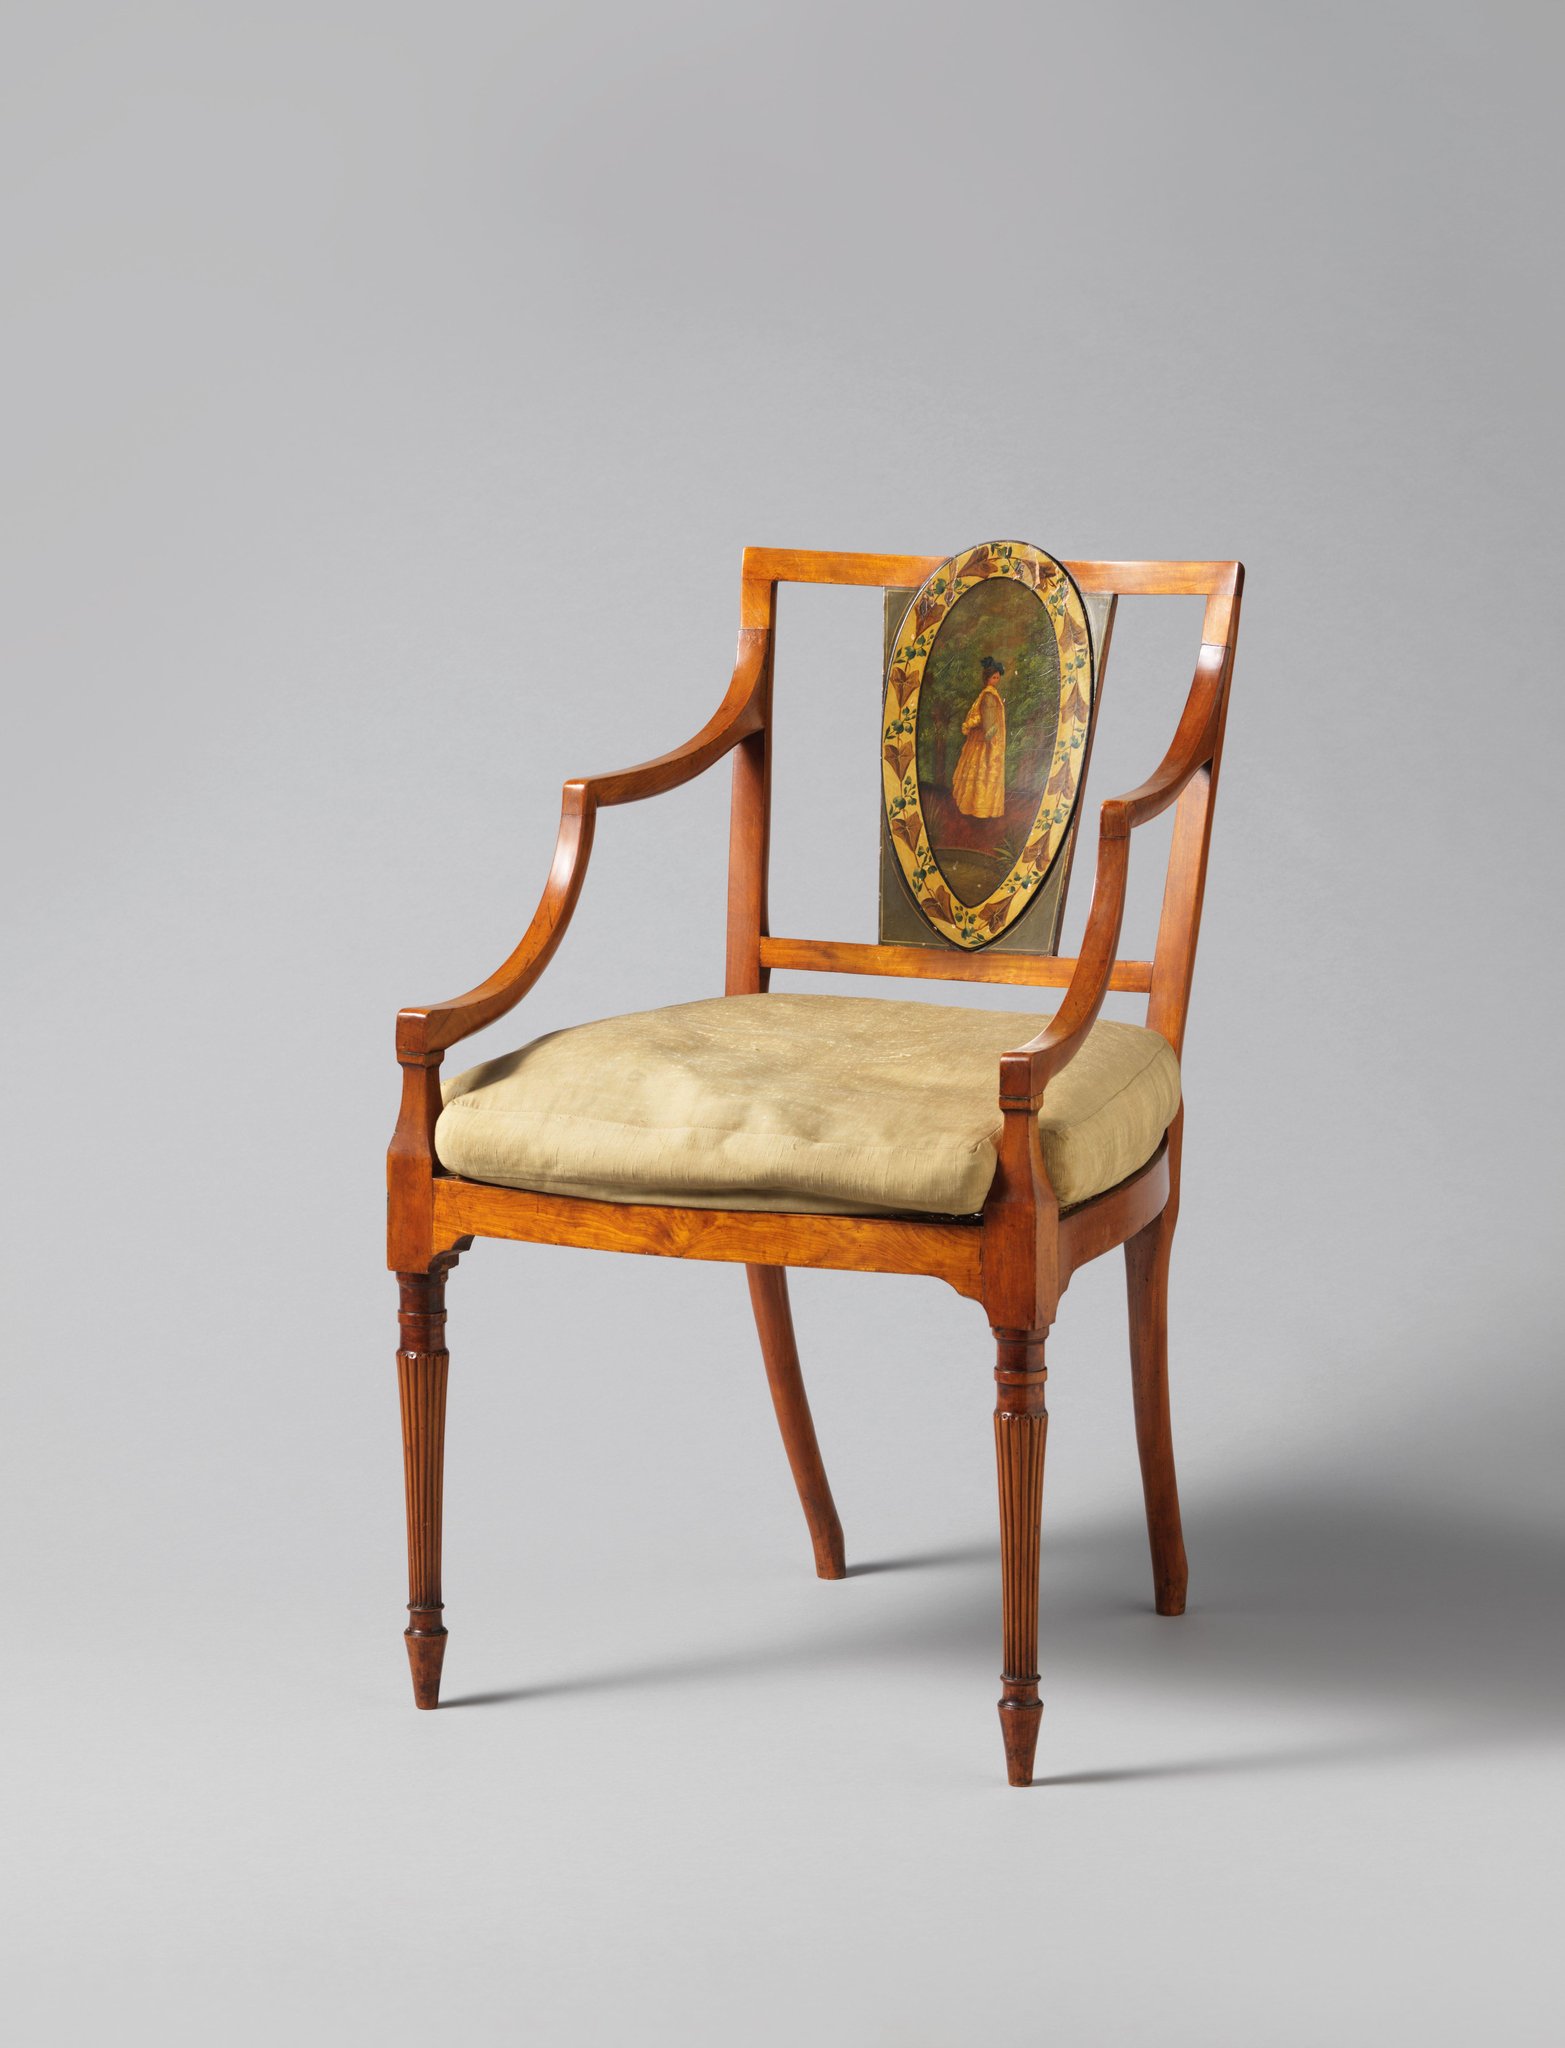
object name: furniture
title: Stoel van gedeeltelijk gefineerd en beschilderd satijnhout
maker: Anonymous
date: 1785-1800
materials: rattan, wood, textile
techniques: painted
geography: great britain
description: Gedeeltelijk gefineerde en beschilderde satijnhouten stoel, rustend op gecanneleerde conische gelede voorpoten en achterwaarts gebogen achterpoten. De verbinding tussen de armleggerstutten en de flauw gebogen armleggers is C-vormig. De rug is flauw gebogen en in het midden versierd met een verticale verbinding, waarop geschilderde medaillons, vrij naar 18de-eeuwse voorstellingen. De zitting is met riet bespannen en voorzien van losse geborduurde kussens. Zie tevens: BK-16137-a t/m c en e/f.